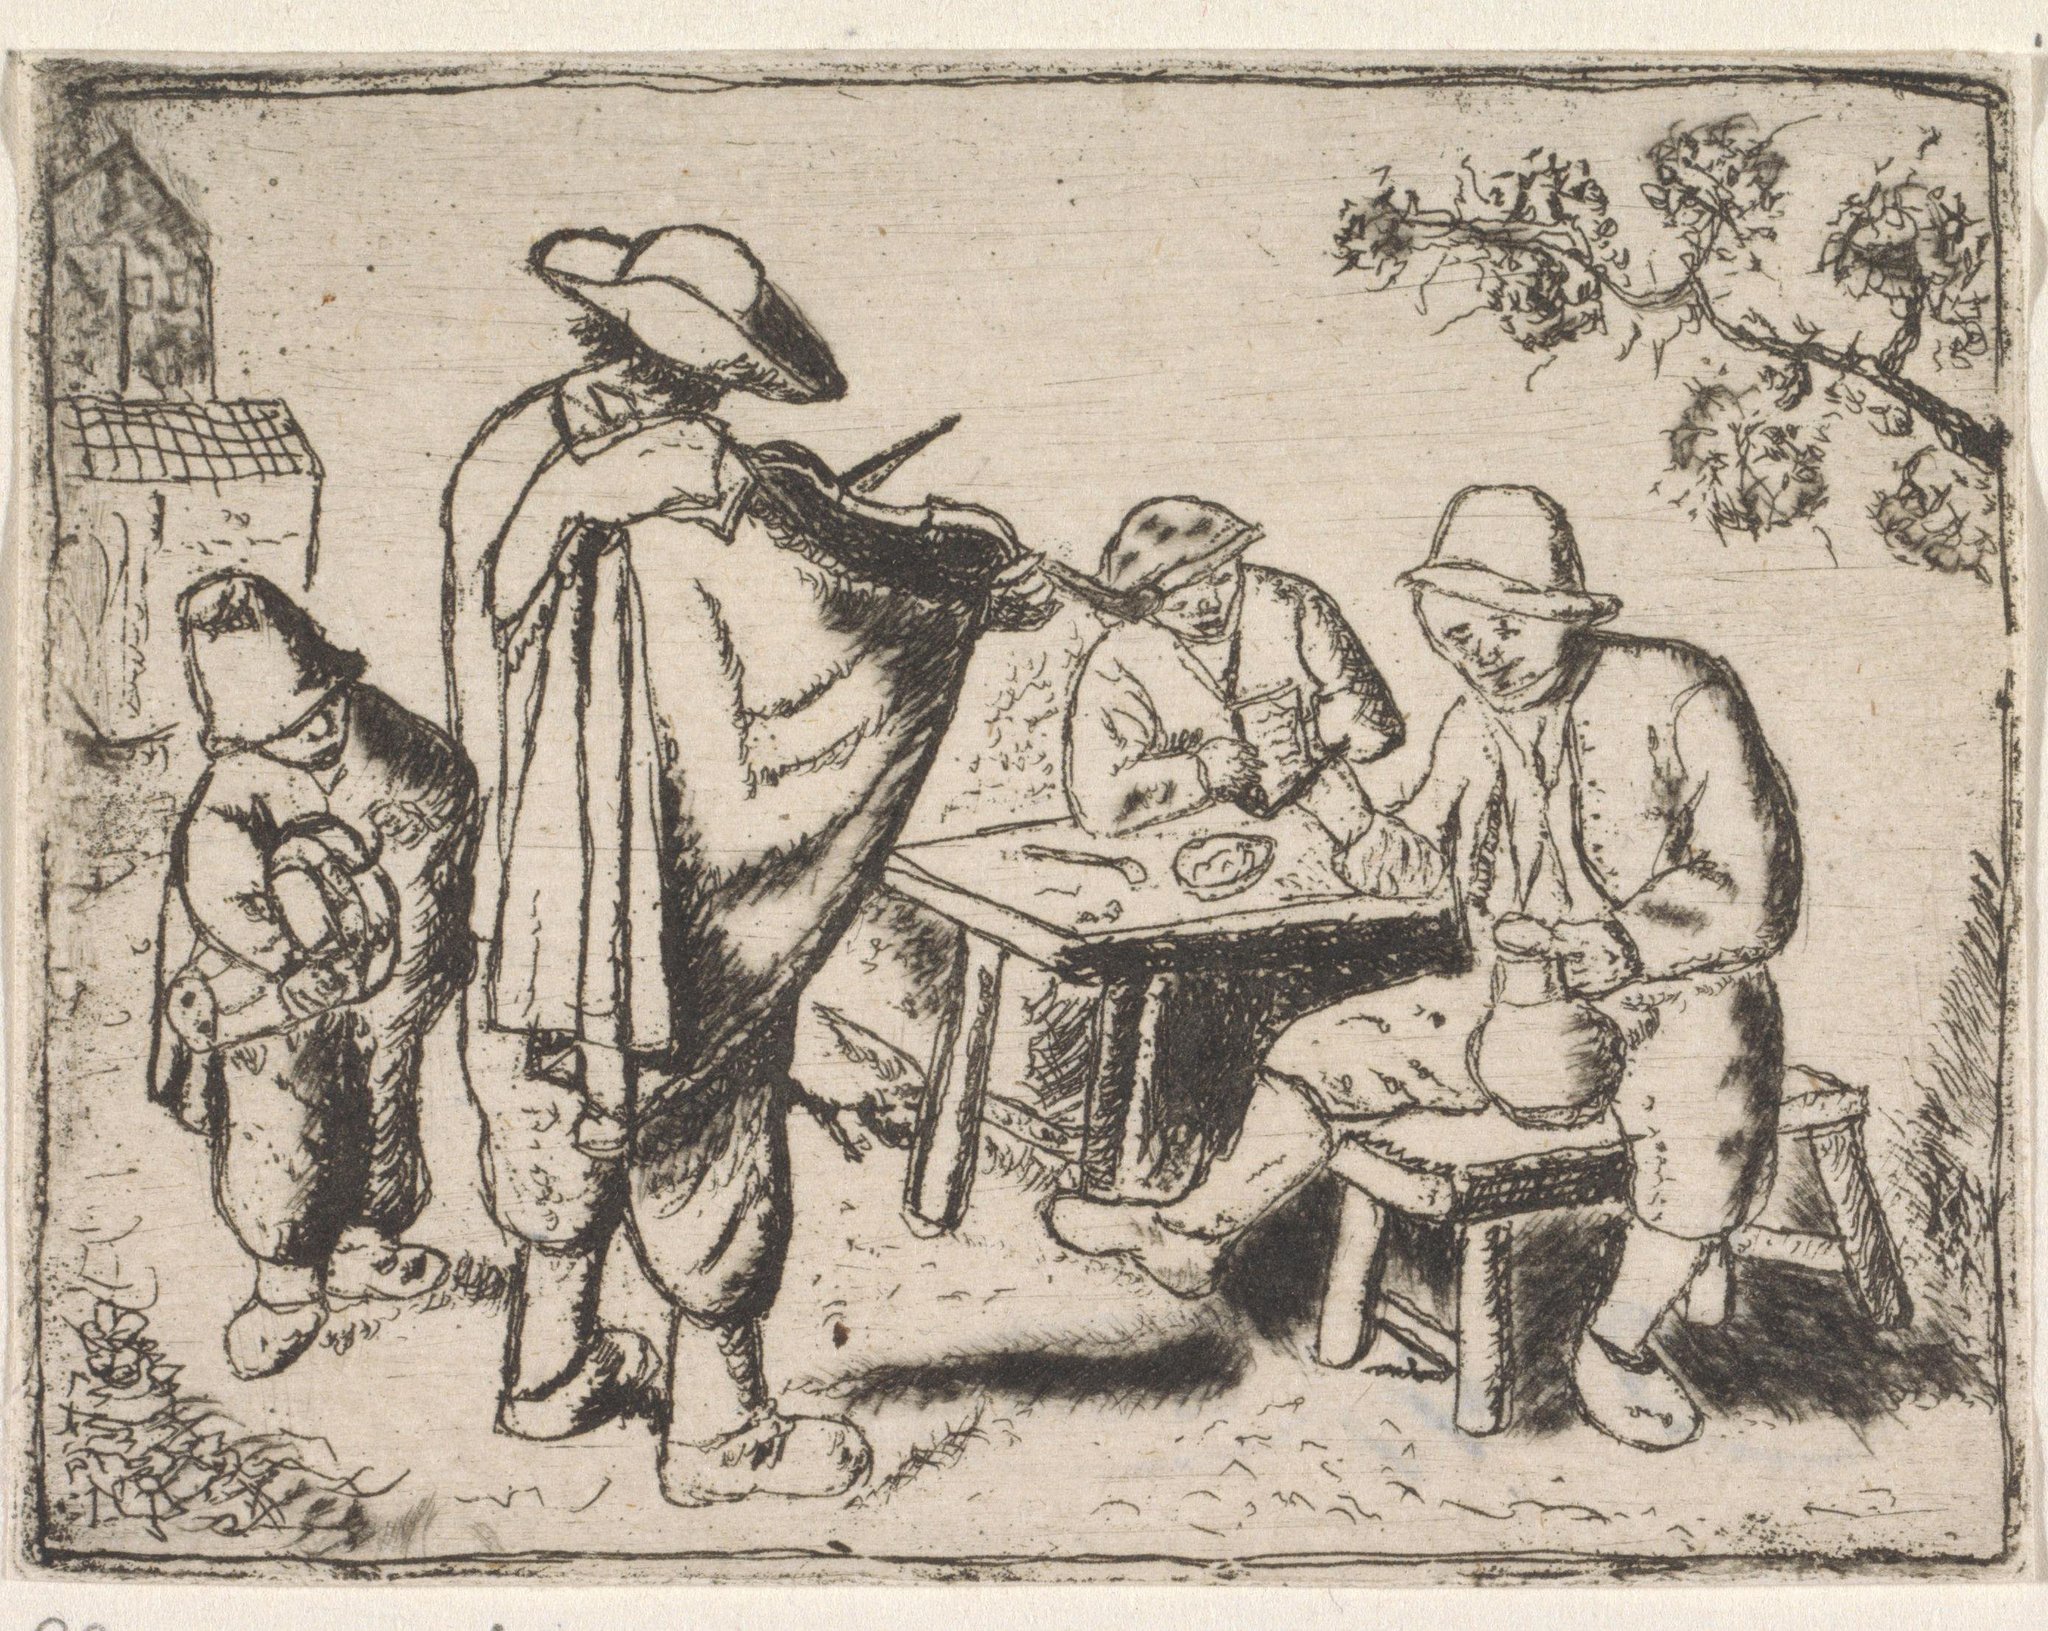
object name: print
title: Vioolspeler en een jonge lierdraaier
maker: Anonymous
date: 1654-1754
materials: paper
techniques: etching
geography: netherlands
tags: hurdy-gurdy, violin, fiddle, more than one musician with instrument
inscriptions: collector's mark: Lugt 2228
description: Twee muzikanten, een man met een viool en een jongen met een lier, vermaken een drinkend gezelschap aan een tafel.